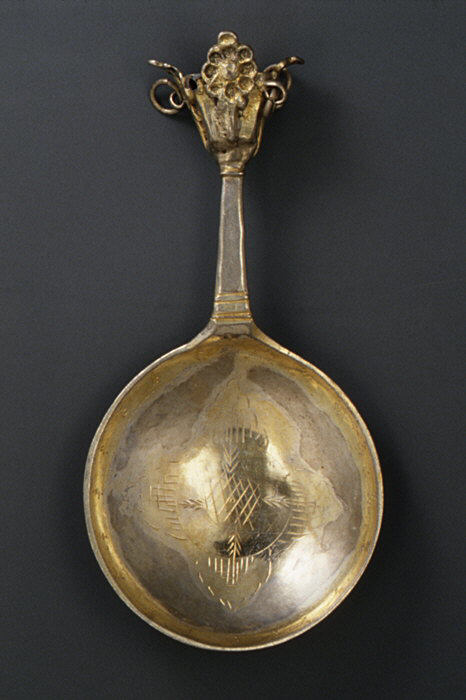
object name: rattle spoon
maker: hans johansson stadius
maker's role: maker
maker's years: 1713-1722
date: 1720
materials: gilt, silver